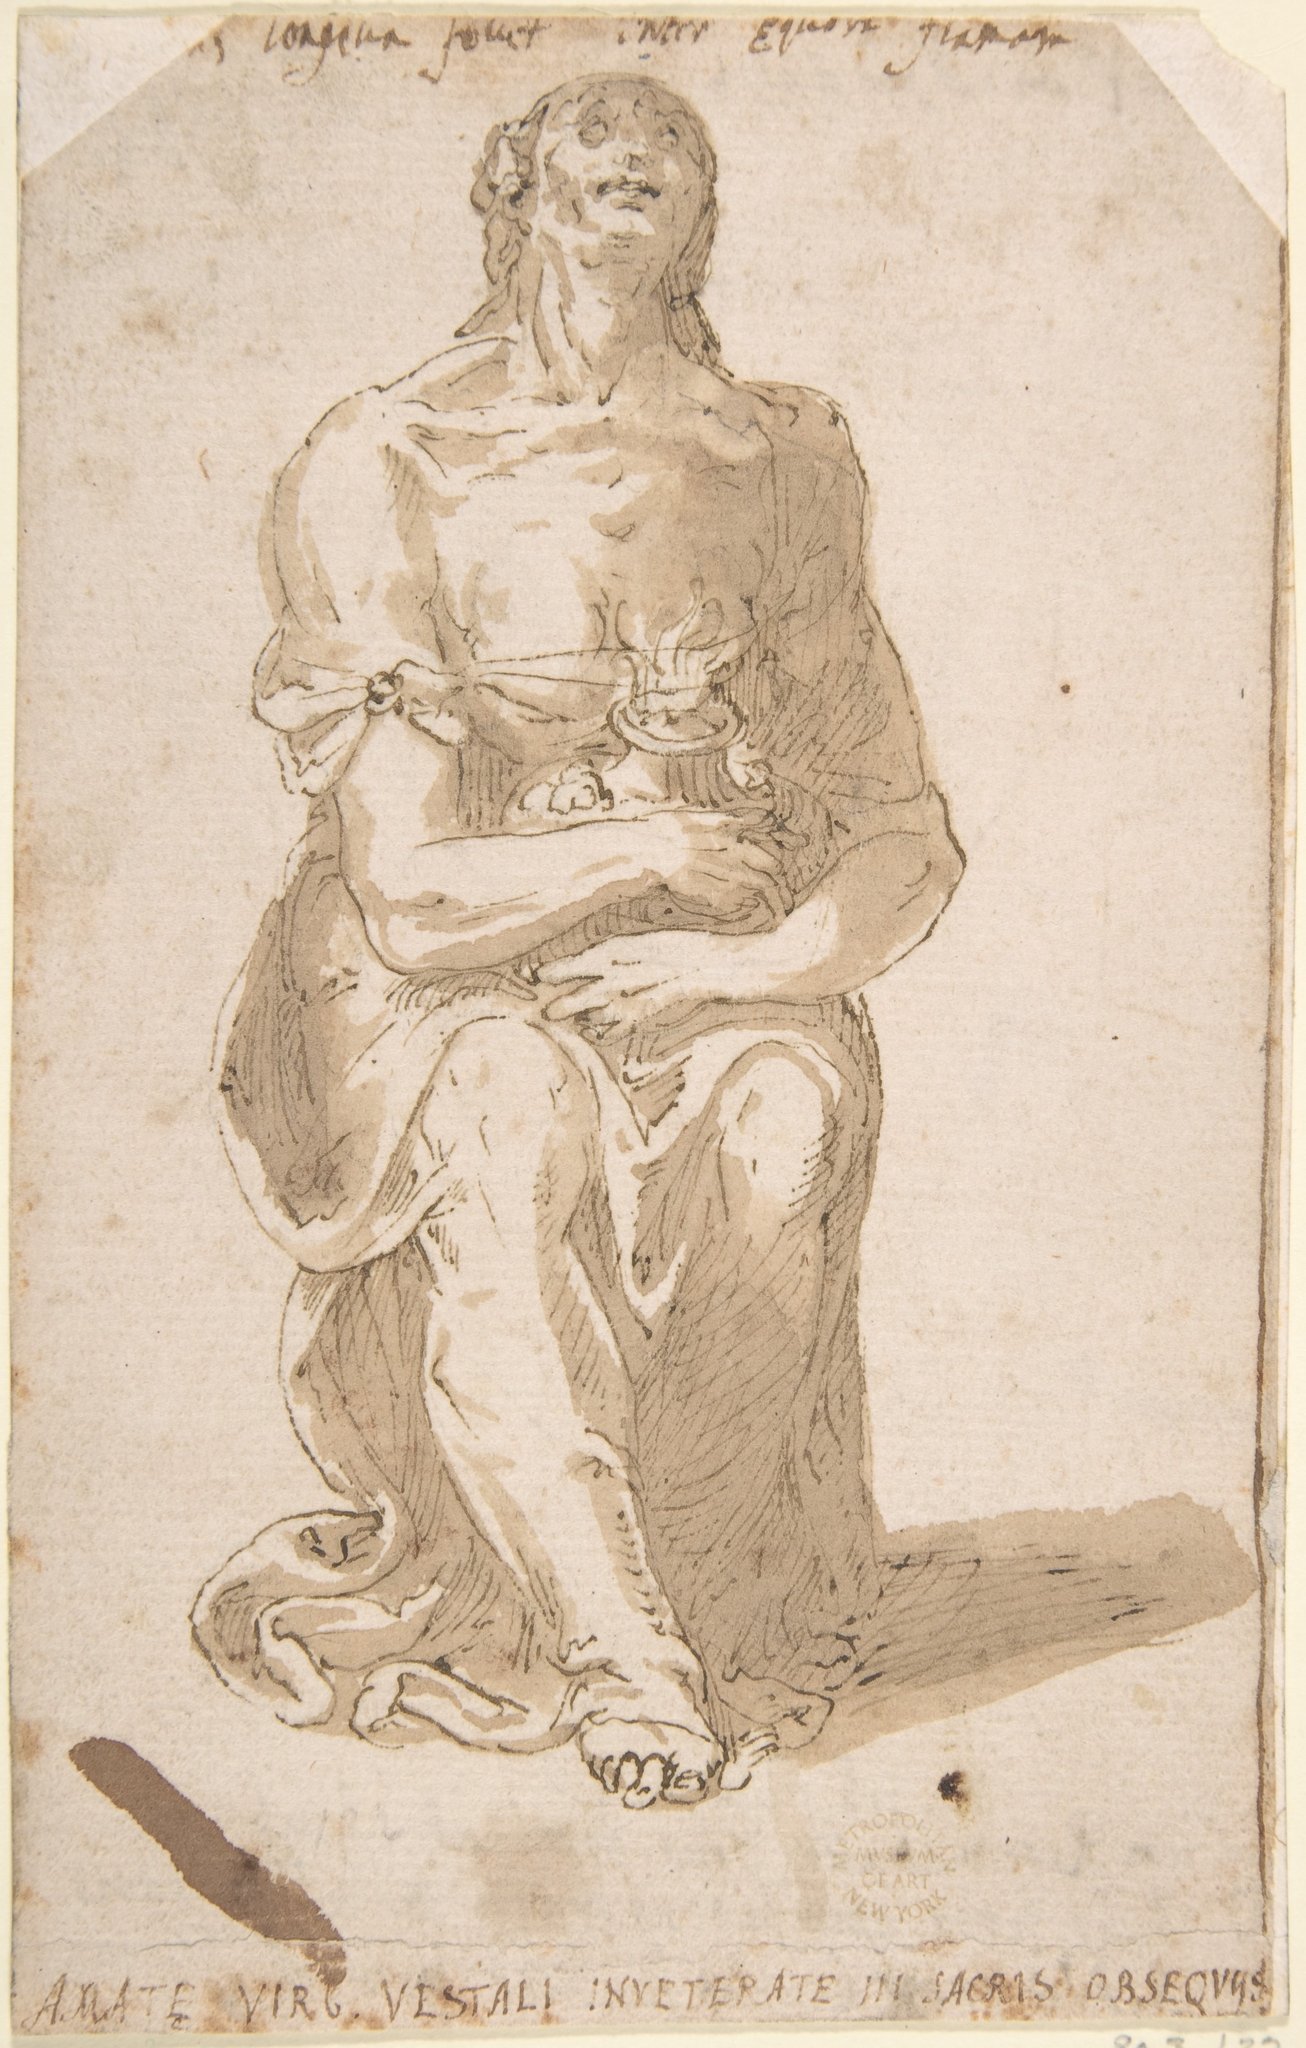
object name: drawing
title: Vestal Virgin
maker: giovanni guerra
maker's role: artist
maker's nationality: italian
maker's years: 1544-1618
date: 1501-1600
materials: ink, paper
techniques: brush, pen, wash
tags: women